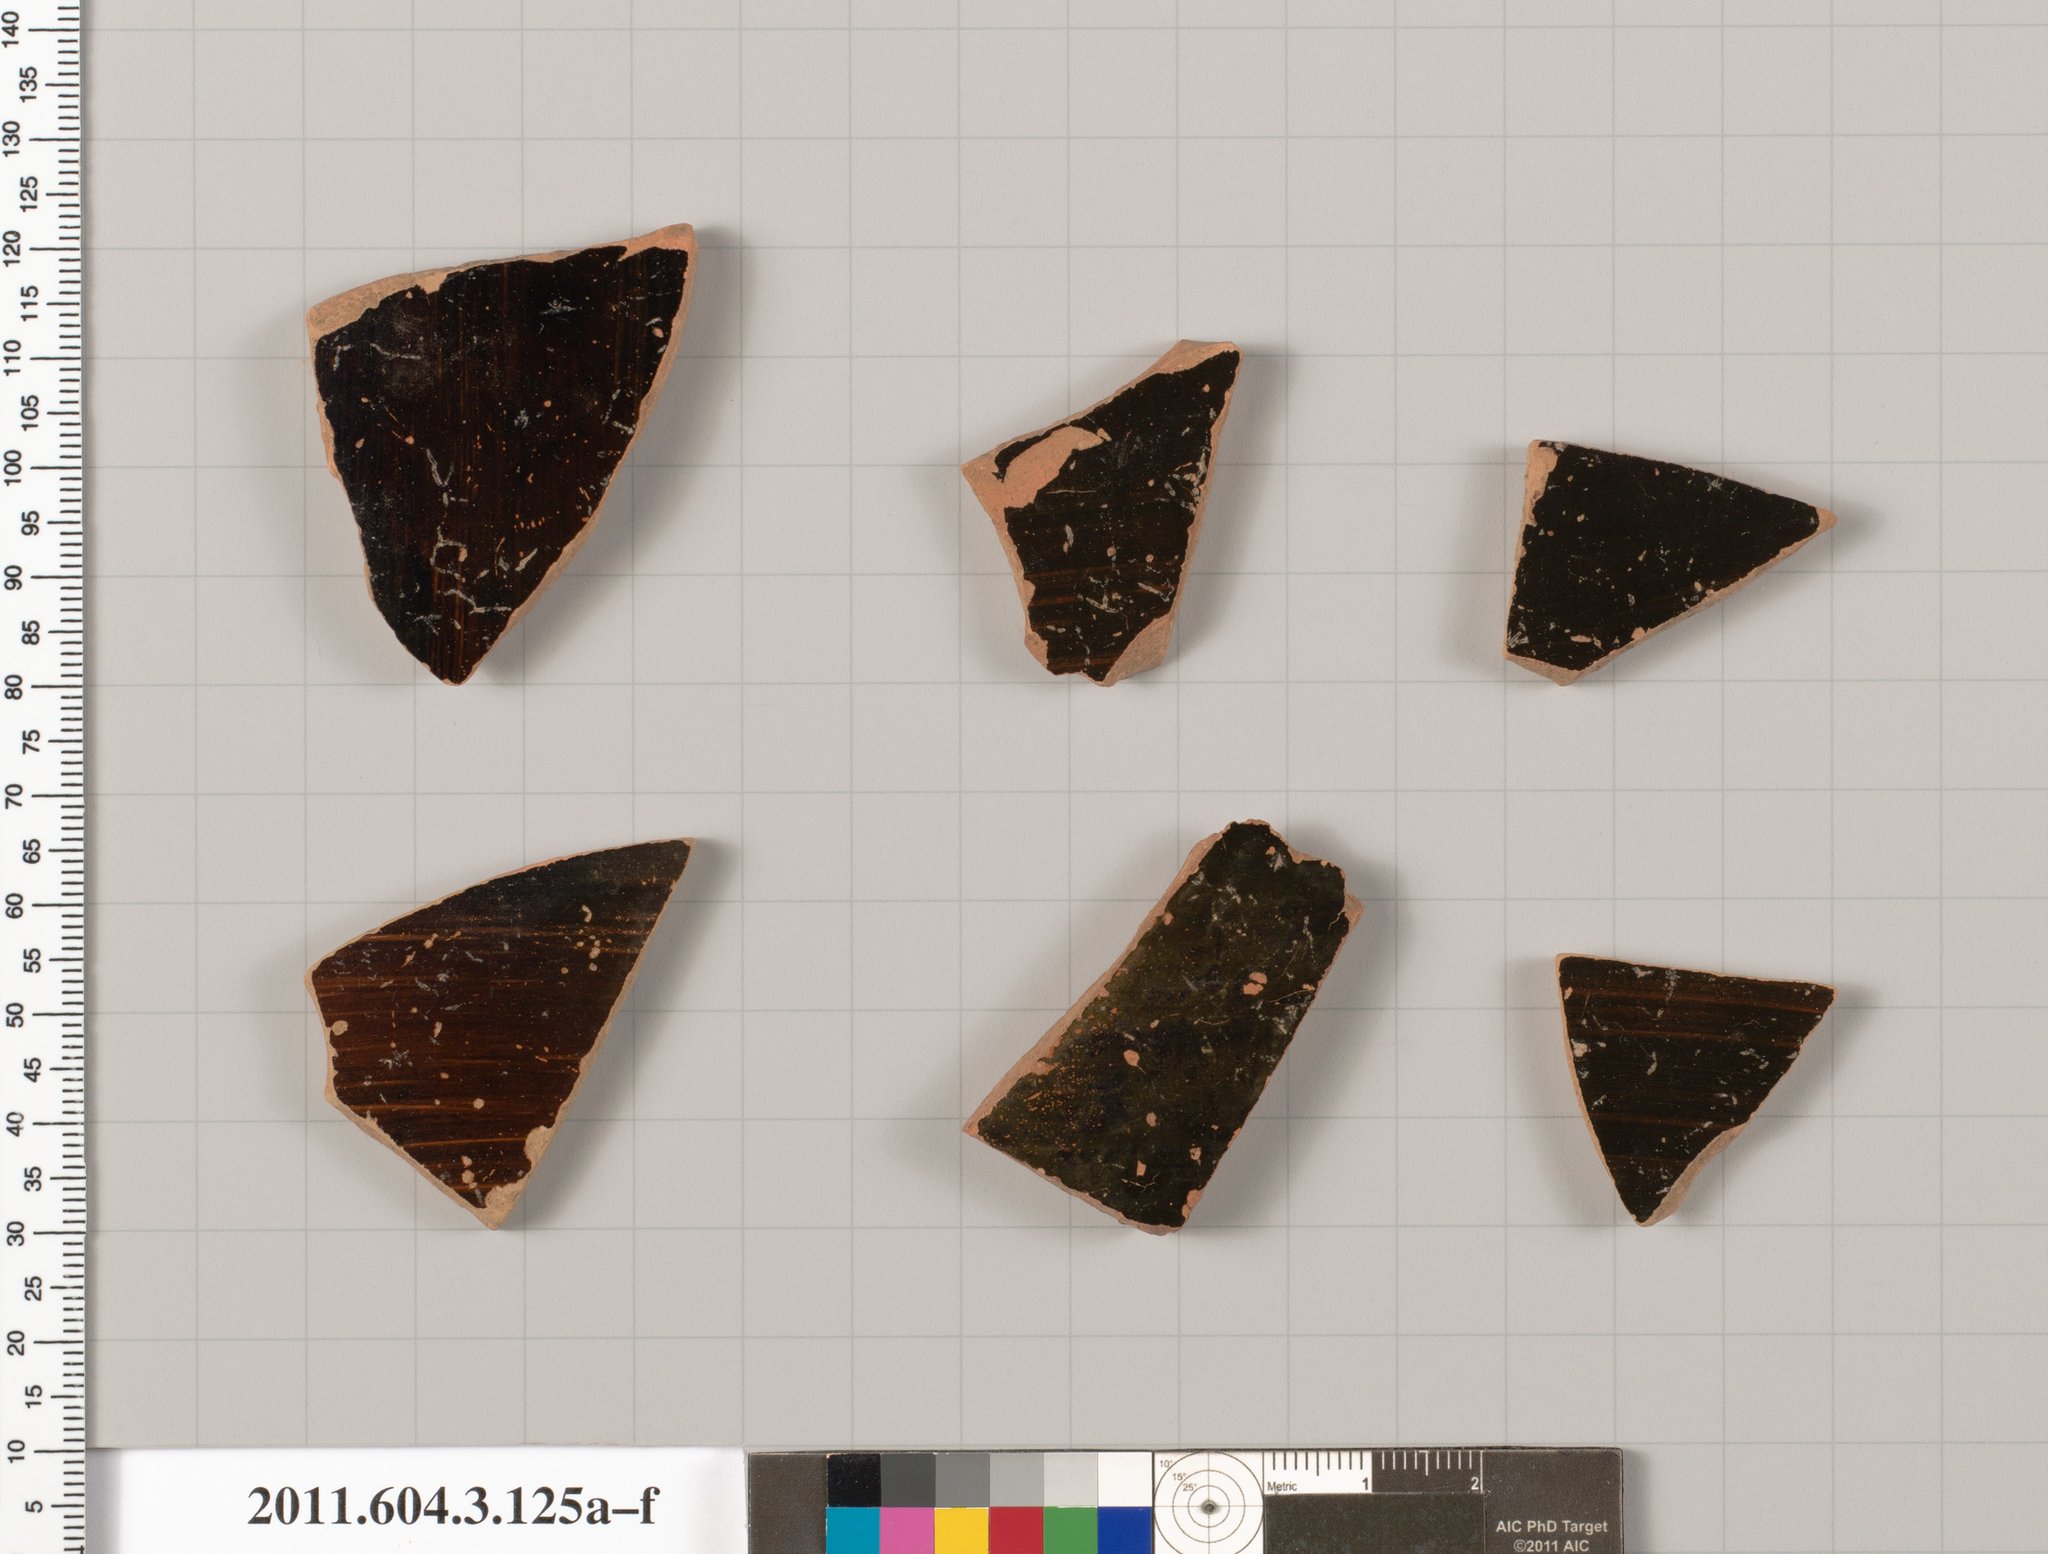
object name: amphora fragment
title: Terracotta fragments of amphorae (jars)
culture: greek, attic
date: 600-468 BCE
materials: terracotta